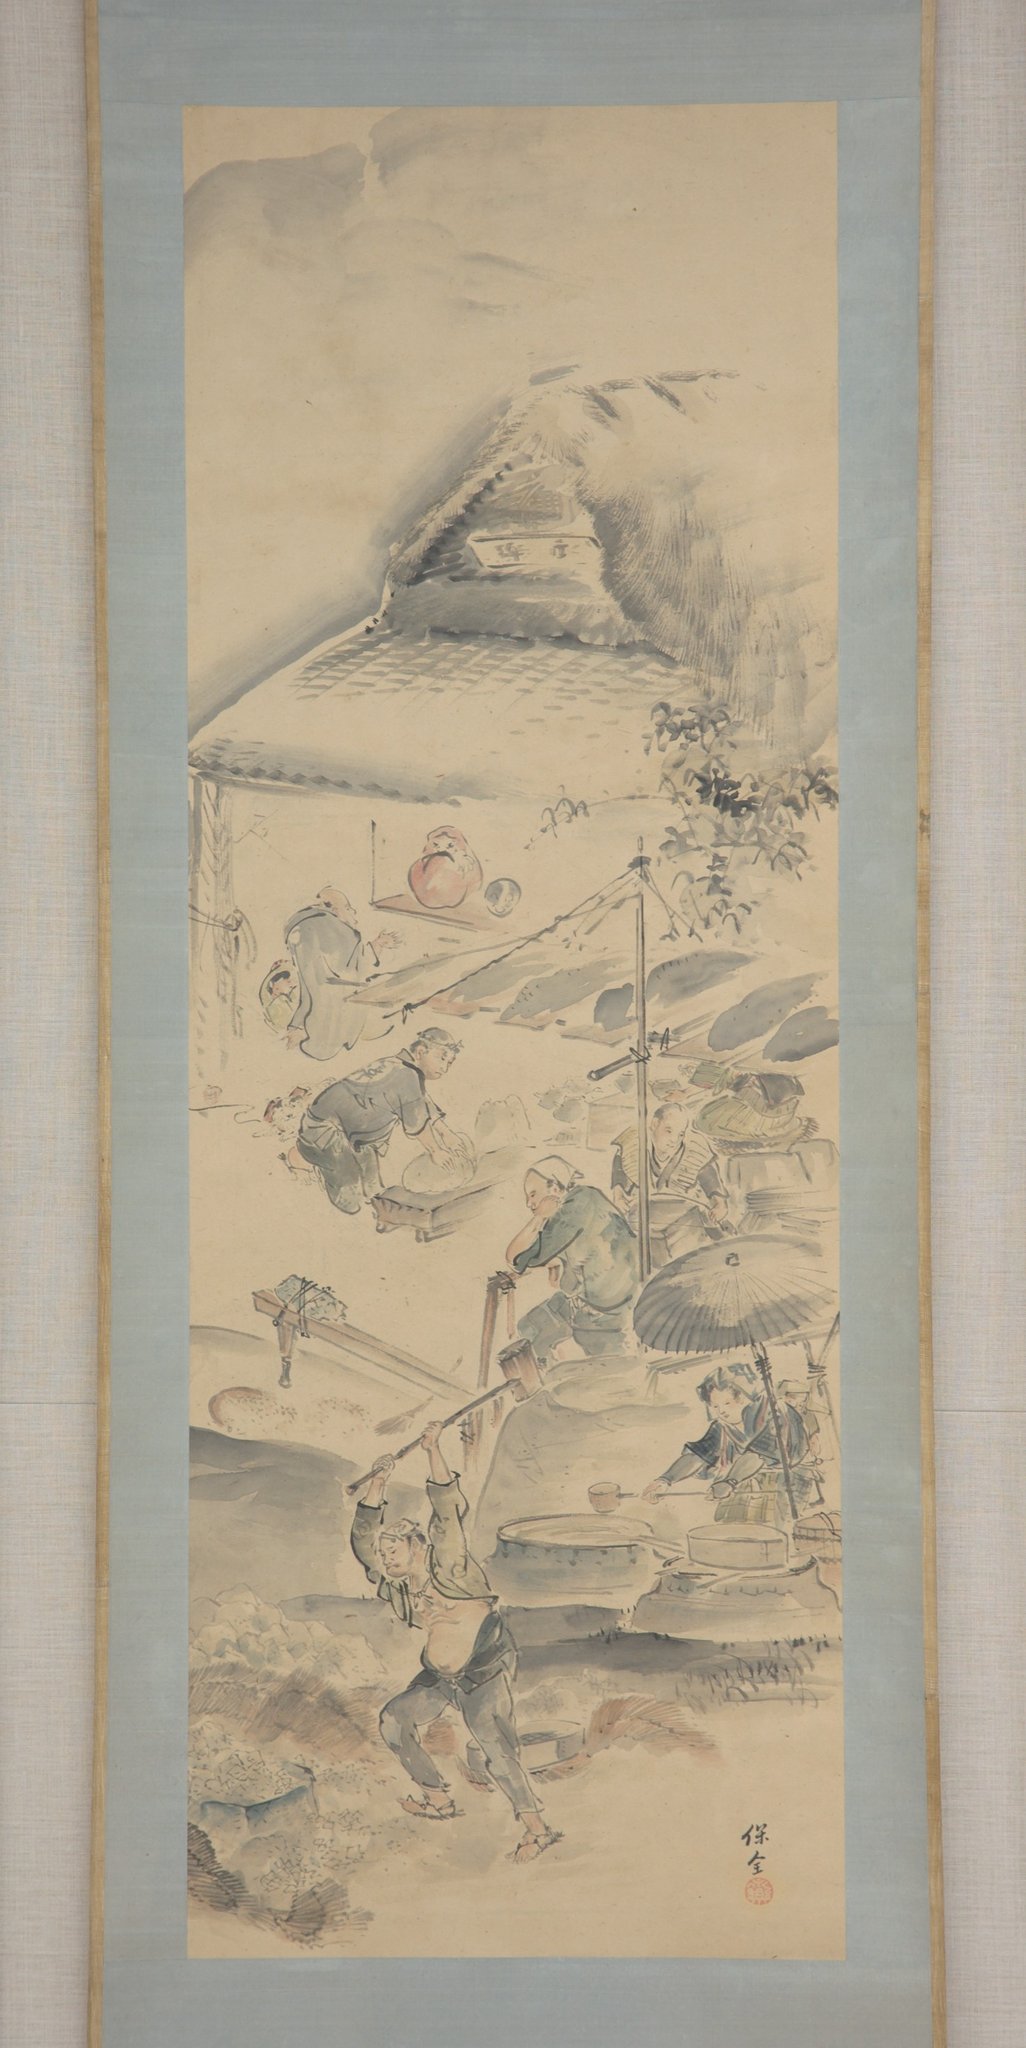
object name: hanging scroll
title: Making Ceramics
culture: japanese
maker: eiraku hozen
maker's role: artist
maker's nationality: japanese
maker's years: 1795-1854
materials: ink, paper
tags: men,working